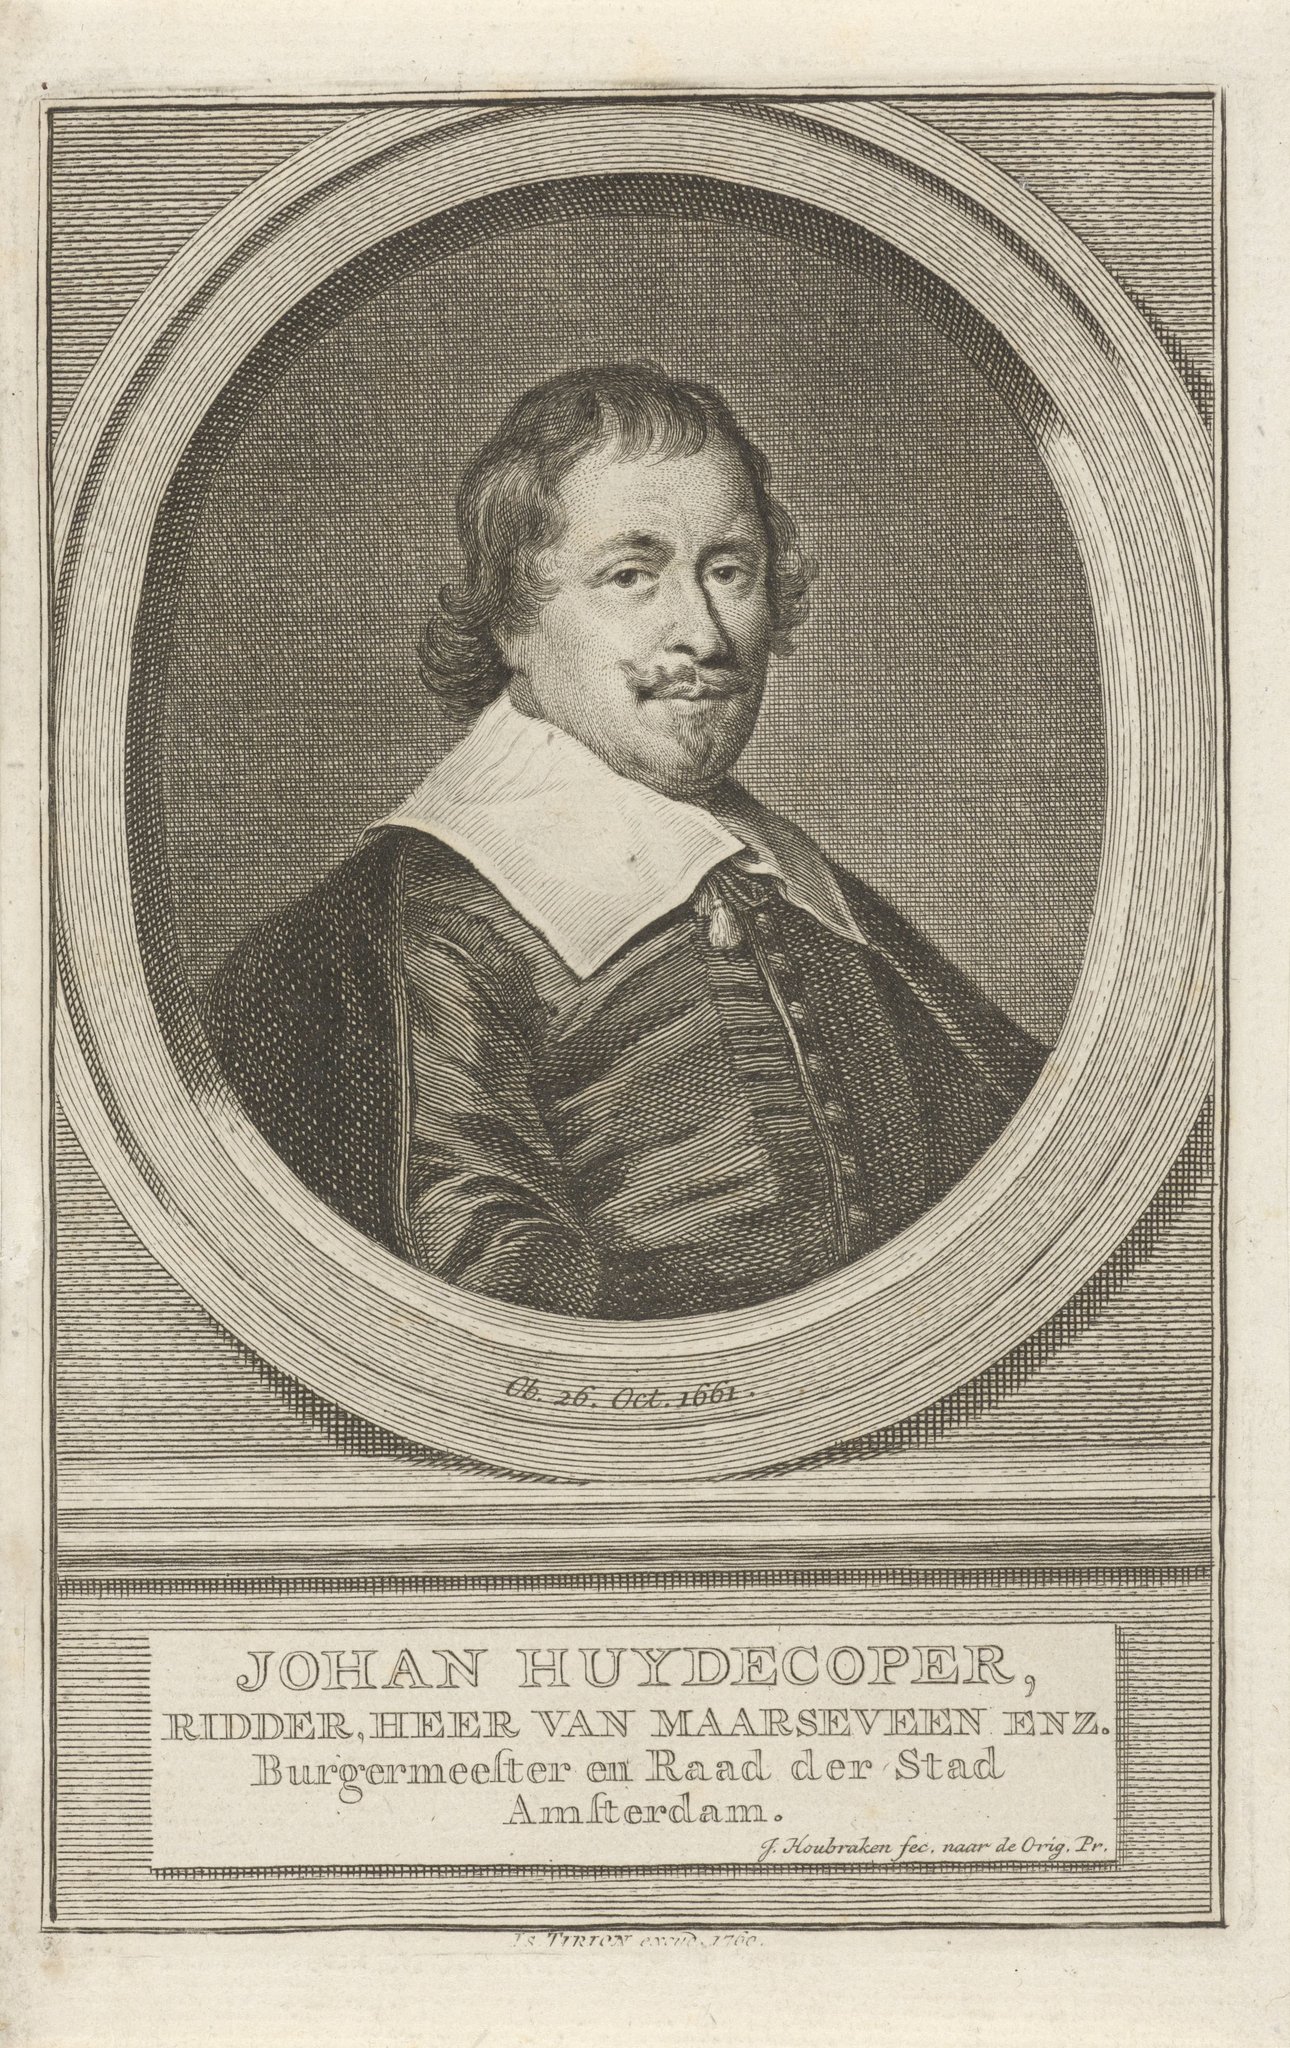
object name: print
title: Johan Huydecoper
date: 1760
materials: paper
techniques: engraving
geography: amsterdam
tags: amsterdam, mayor, joan huydecoper van maarseveen (i)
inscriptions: collector's mark: Lugt 2228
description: Buste naar rechts van Joan Huydecoper I van Maarseveen, in een ovaal. Het portret rust op een plint waarop zijn naam en gegevens in vier regels in het Nederlands.